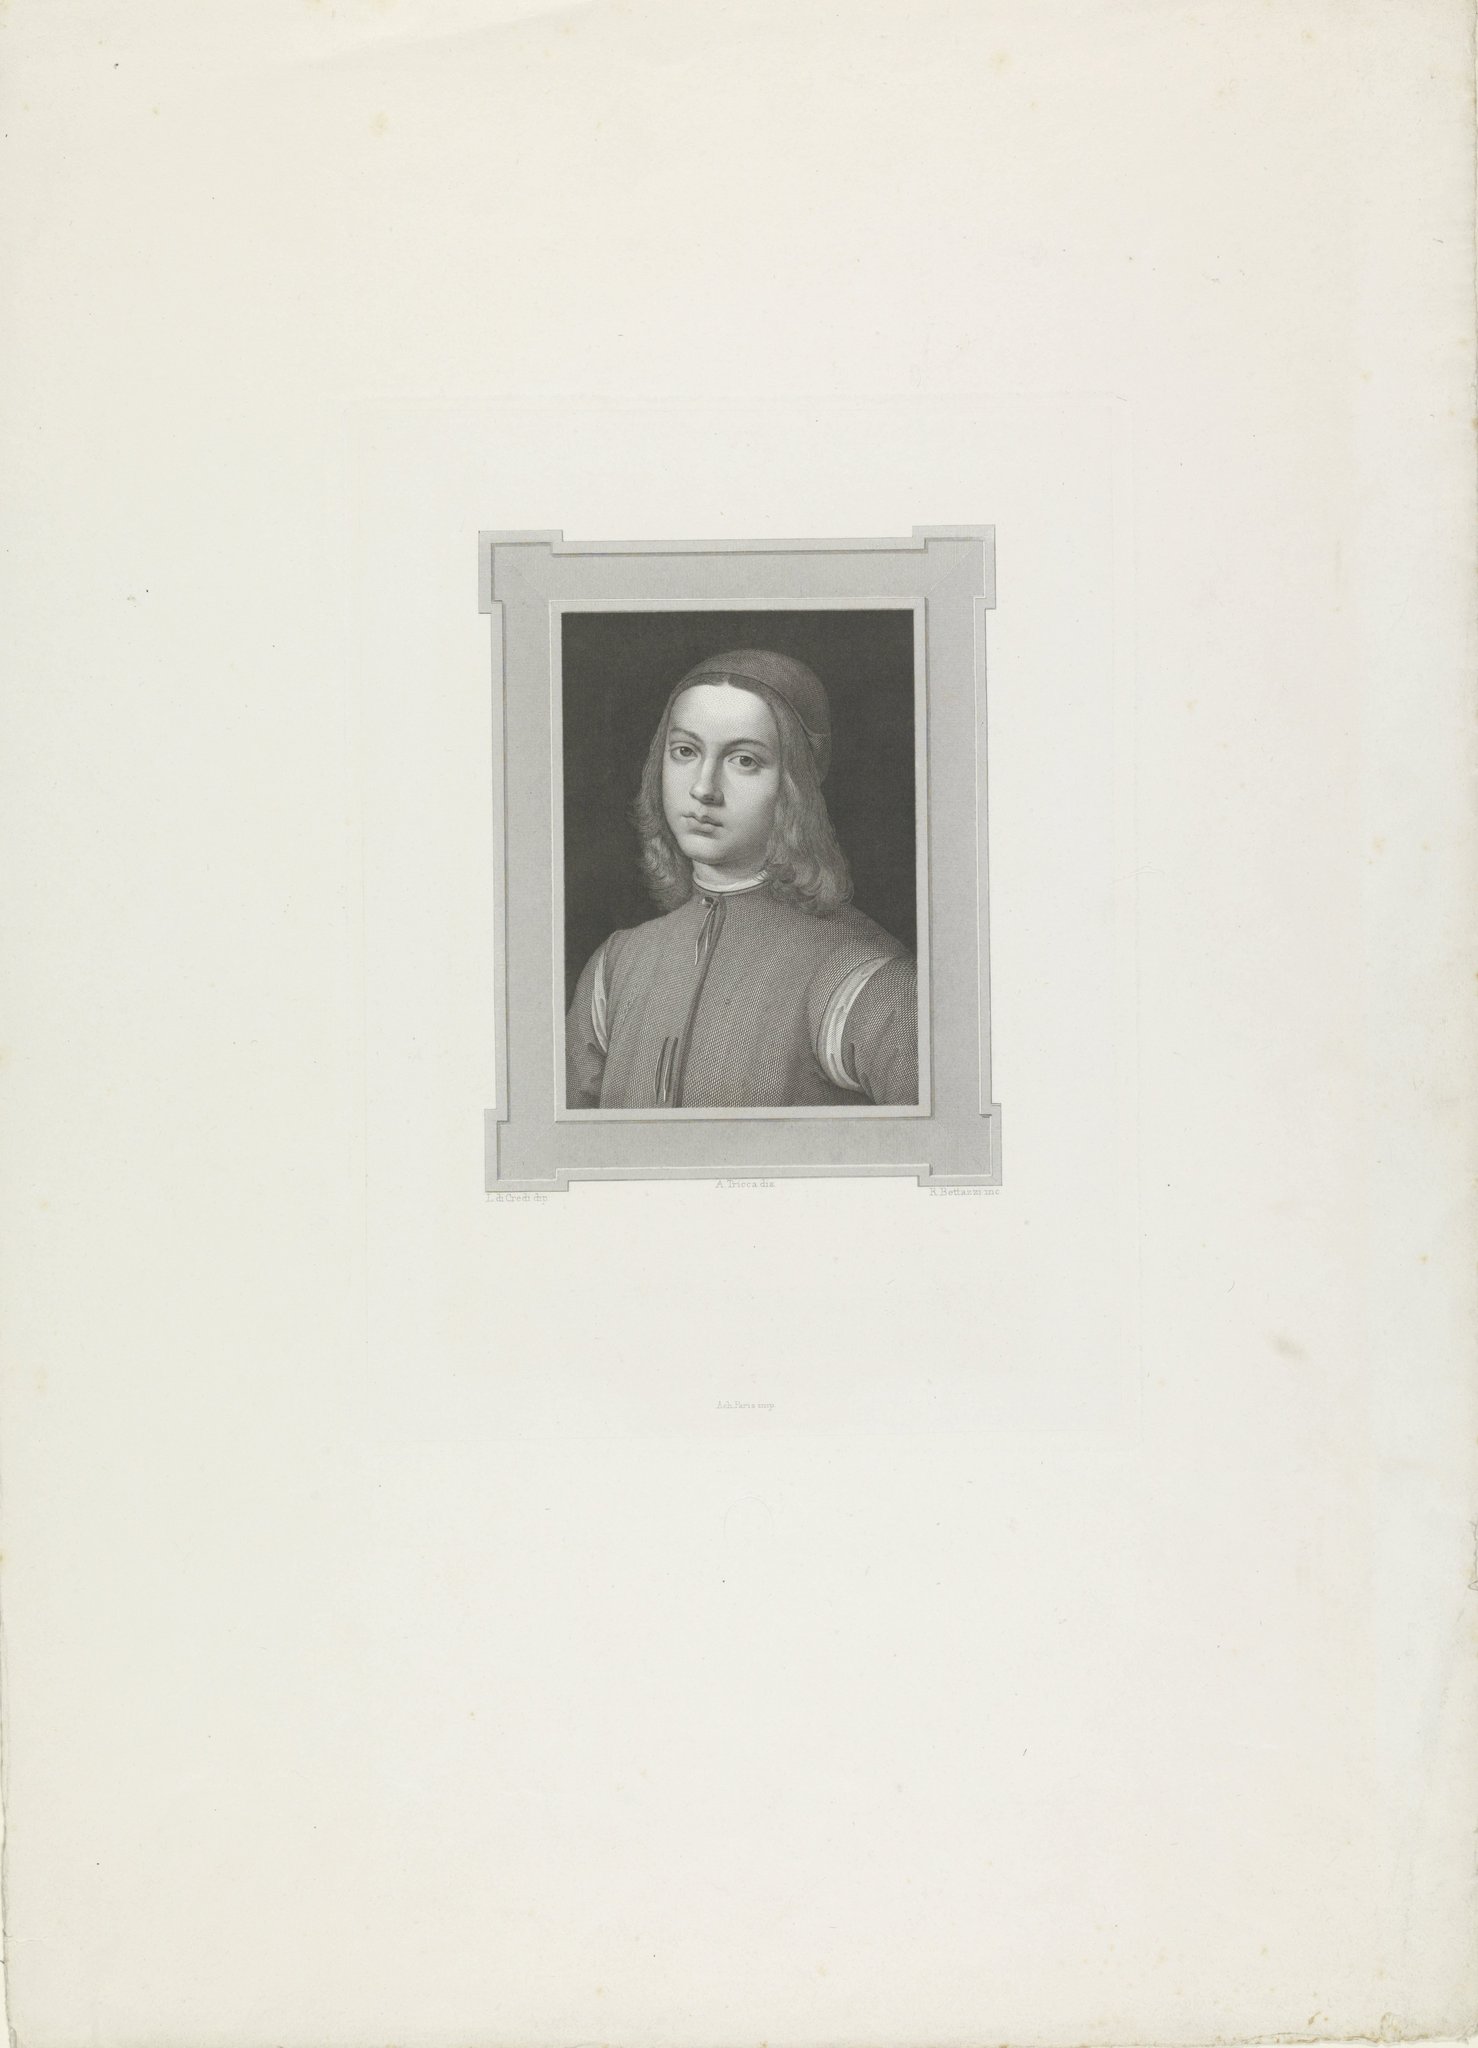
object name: print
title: Portret van een jongeman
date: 1834-1868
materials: paper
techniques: engraving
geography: italy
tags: historical persons, youth, adolescent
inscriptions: collector's mark